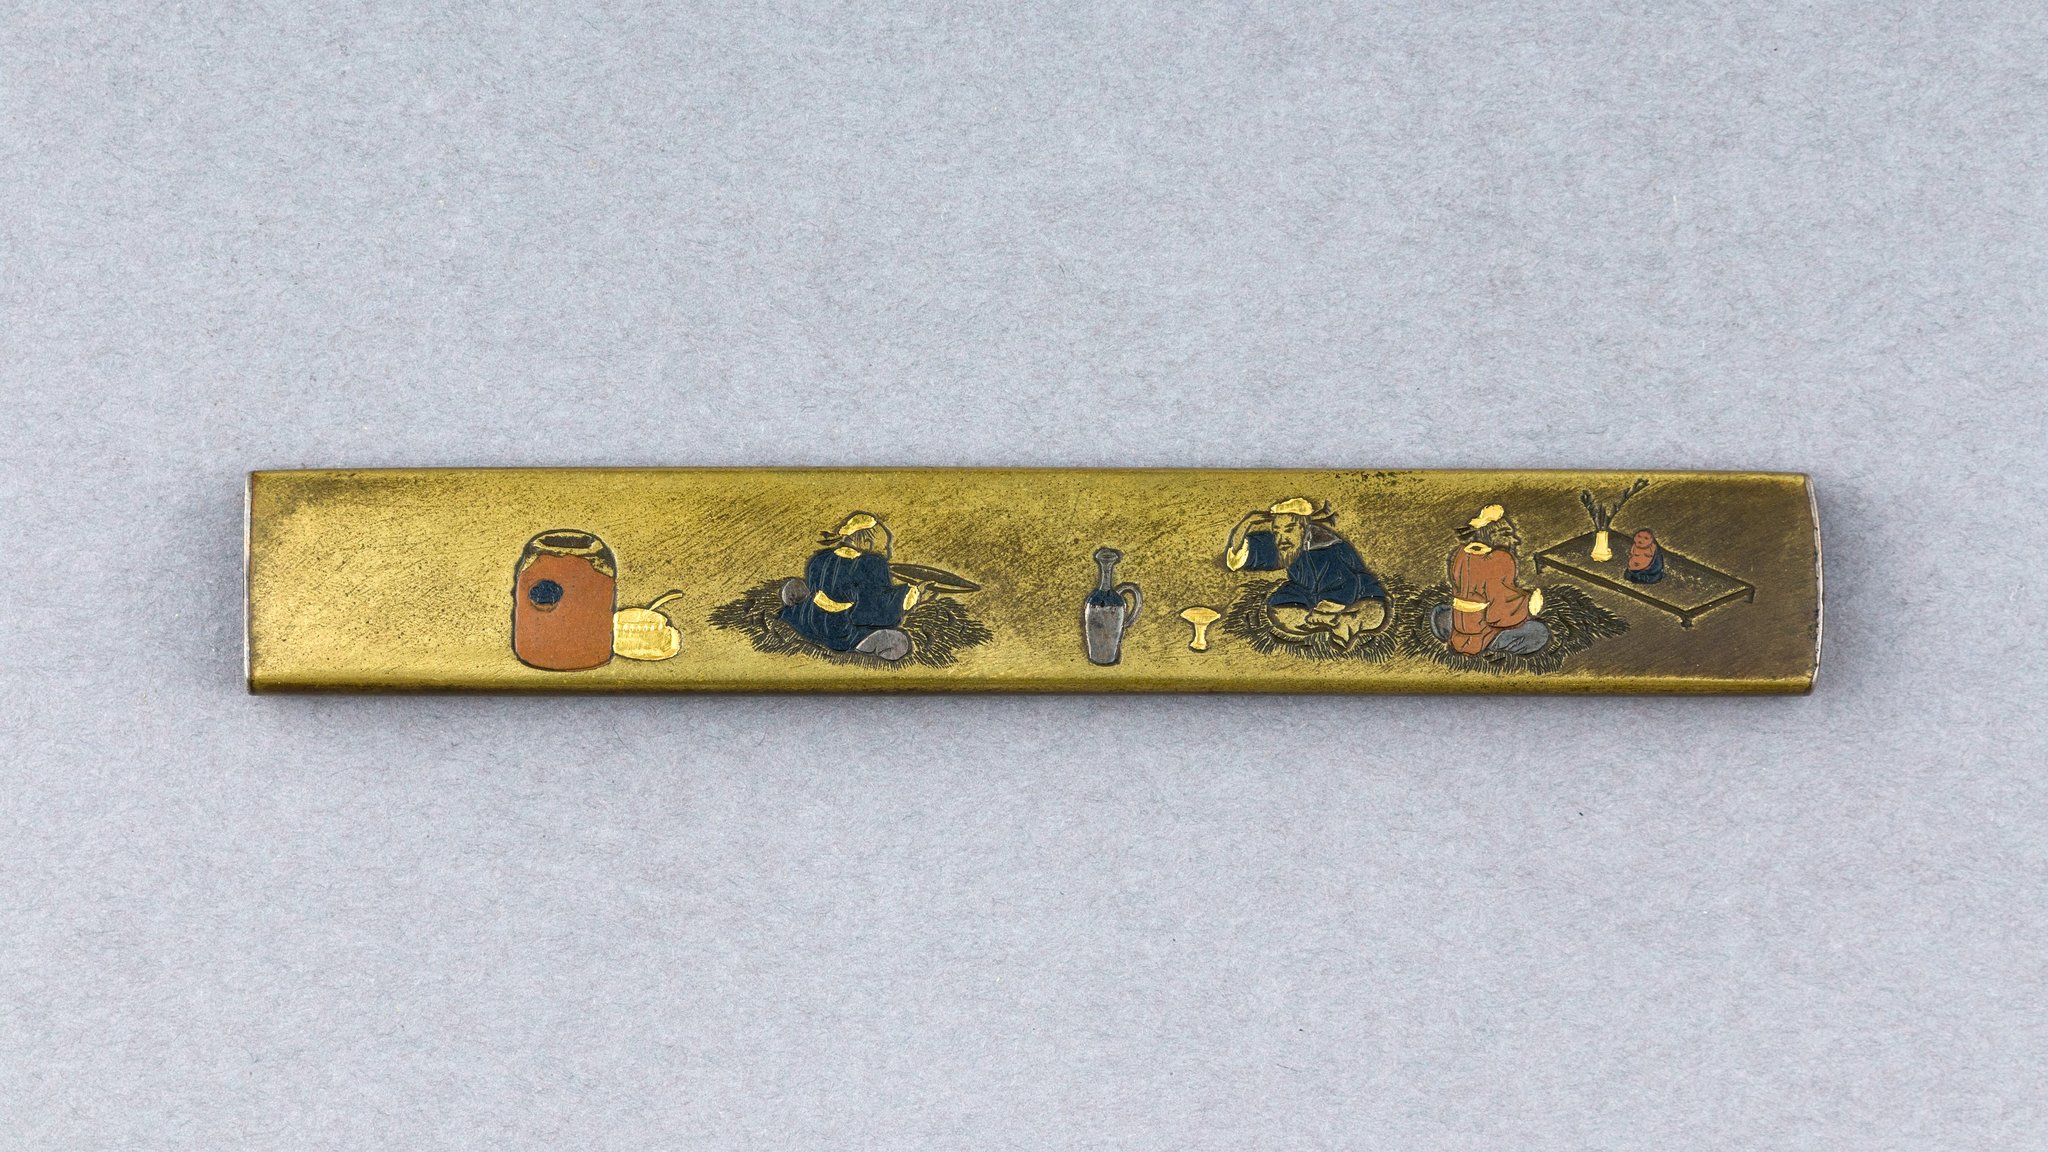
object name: knife handle kozuka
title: Knife Handle (Kozuka)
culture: japanese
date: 1615-1868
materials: copper, copper alloy, silver alloy, gold, silver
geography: japan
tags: men